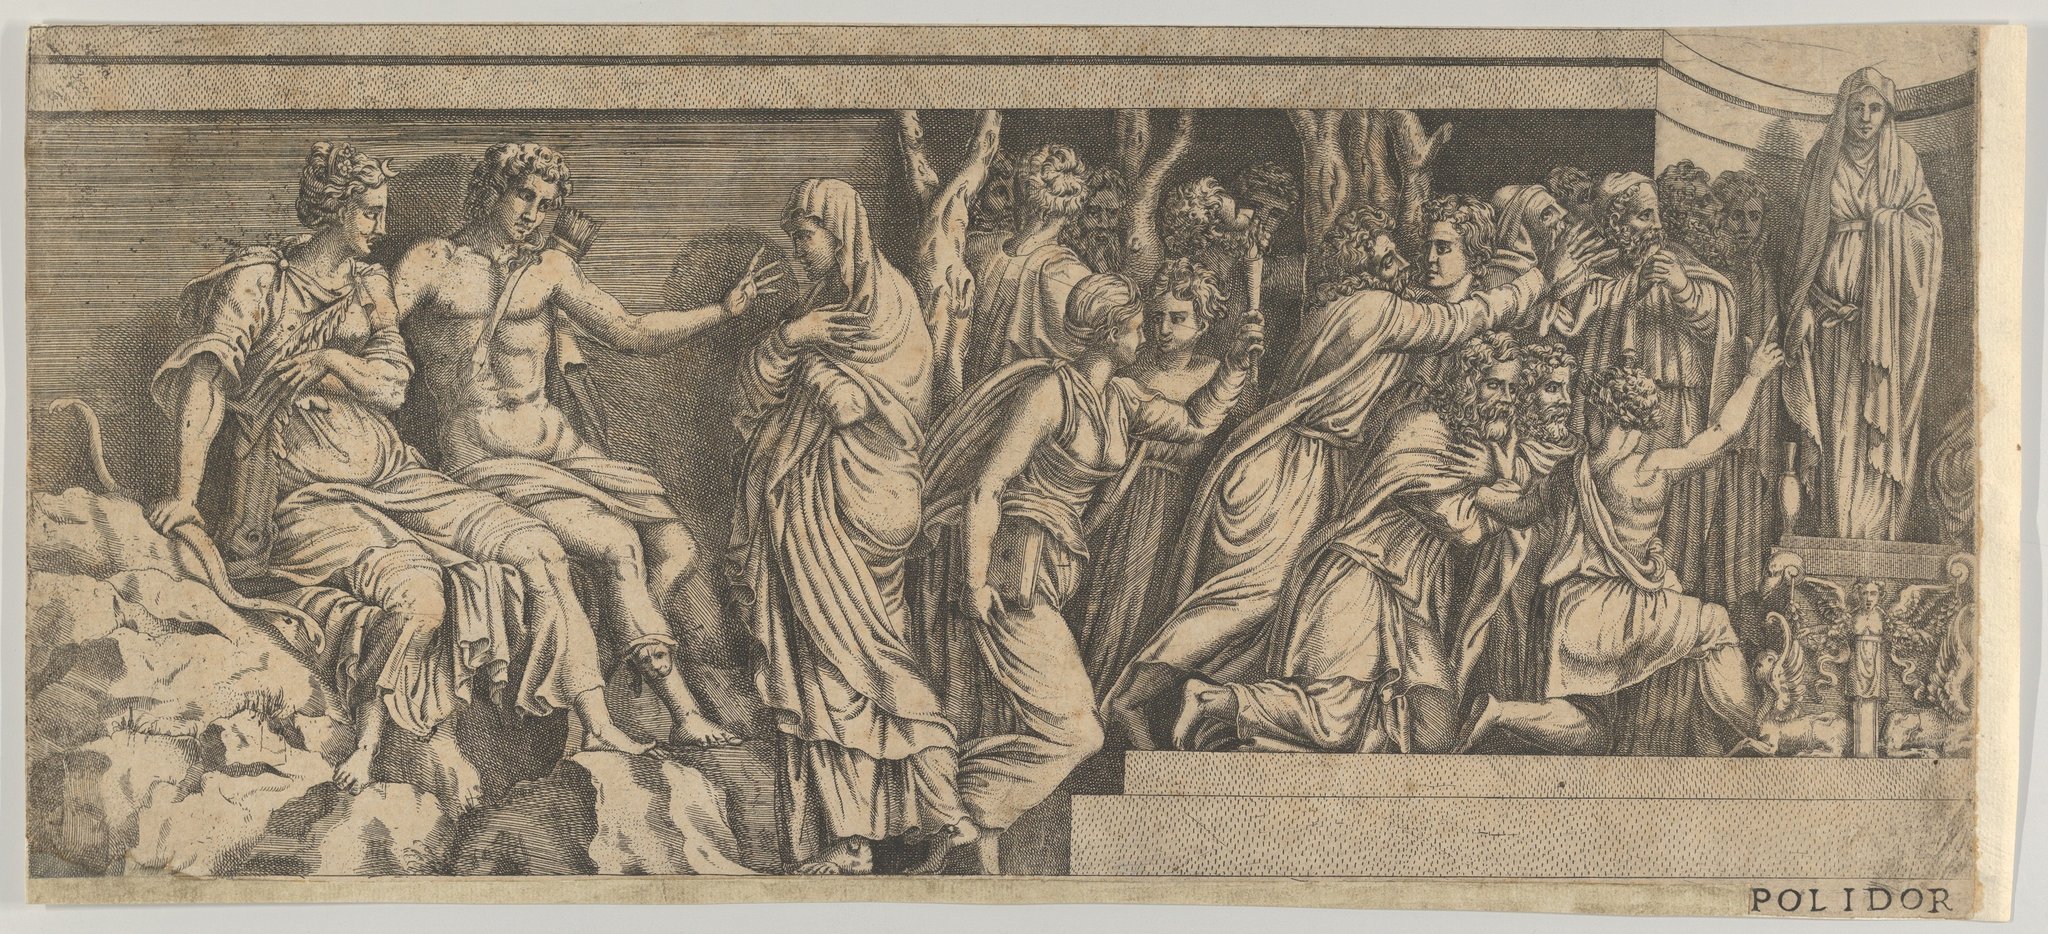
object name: print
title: Statue of Niobe and her Worshippers, with Apollo and Diana and other Figures, after Polidoro da Caravaggio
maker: anonymous, school of fontainebleau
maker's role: artist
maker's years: 1500-1600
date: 1543-1547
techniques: etching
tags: men,women,apollo,diana,praying